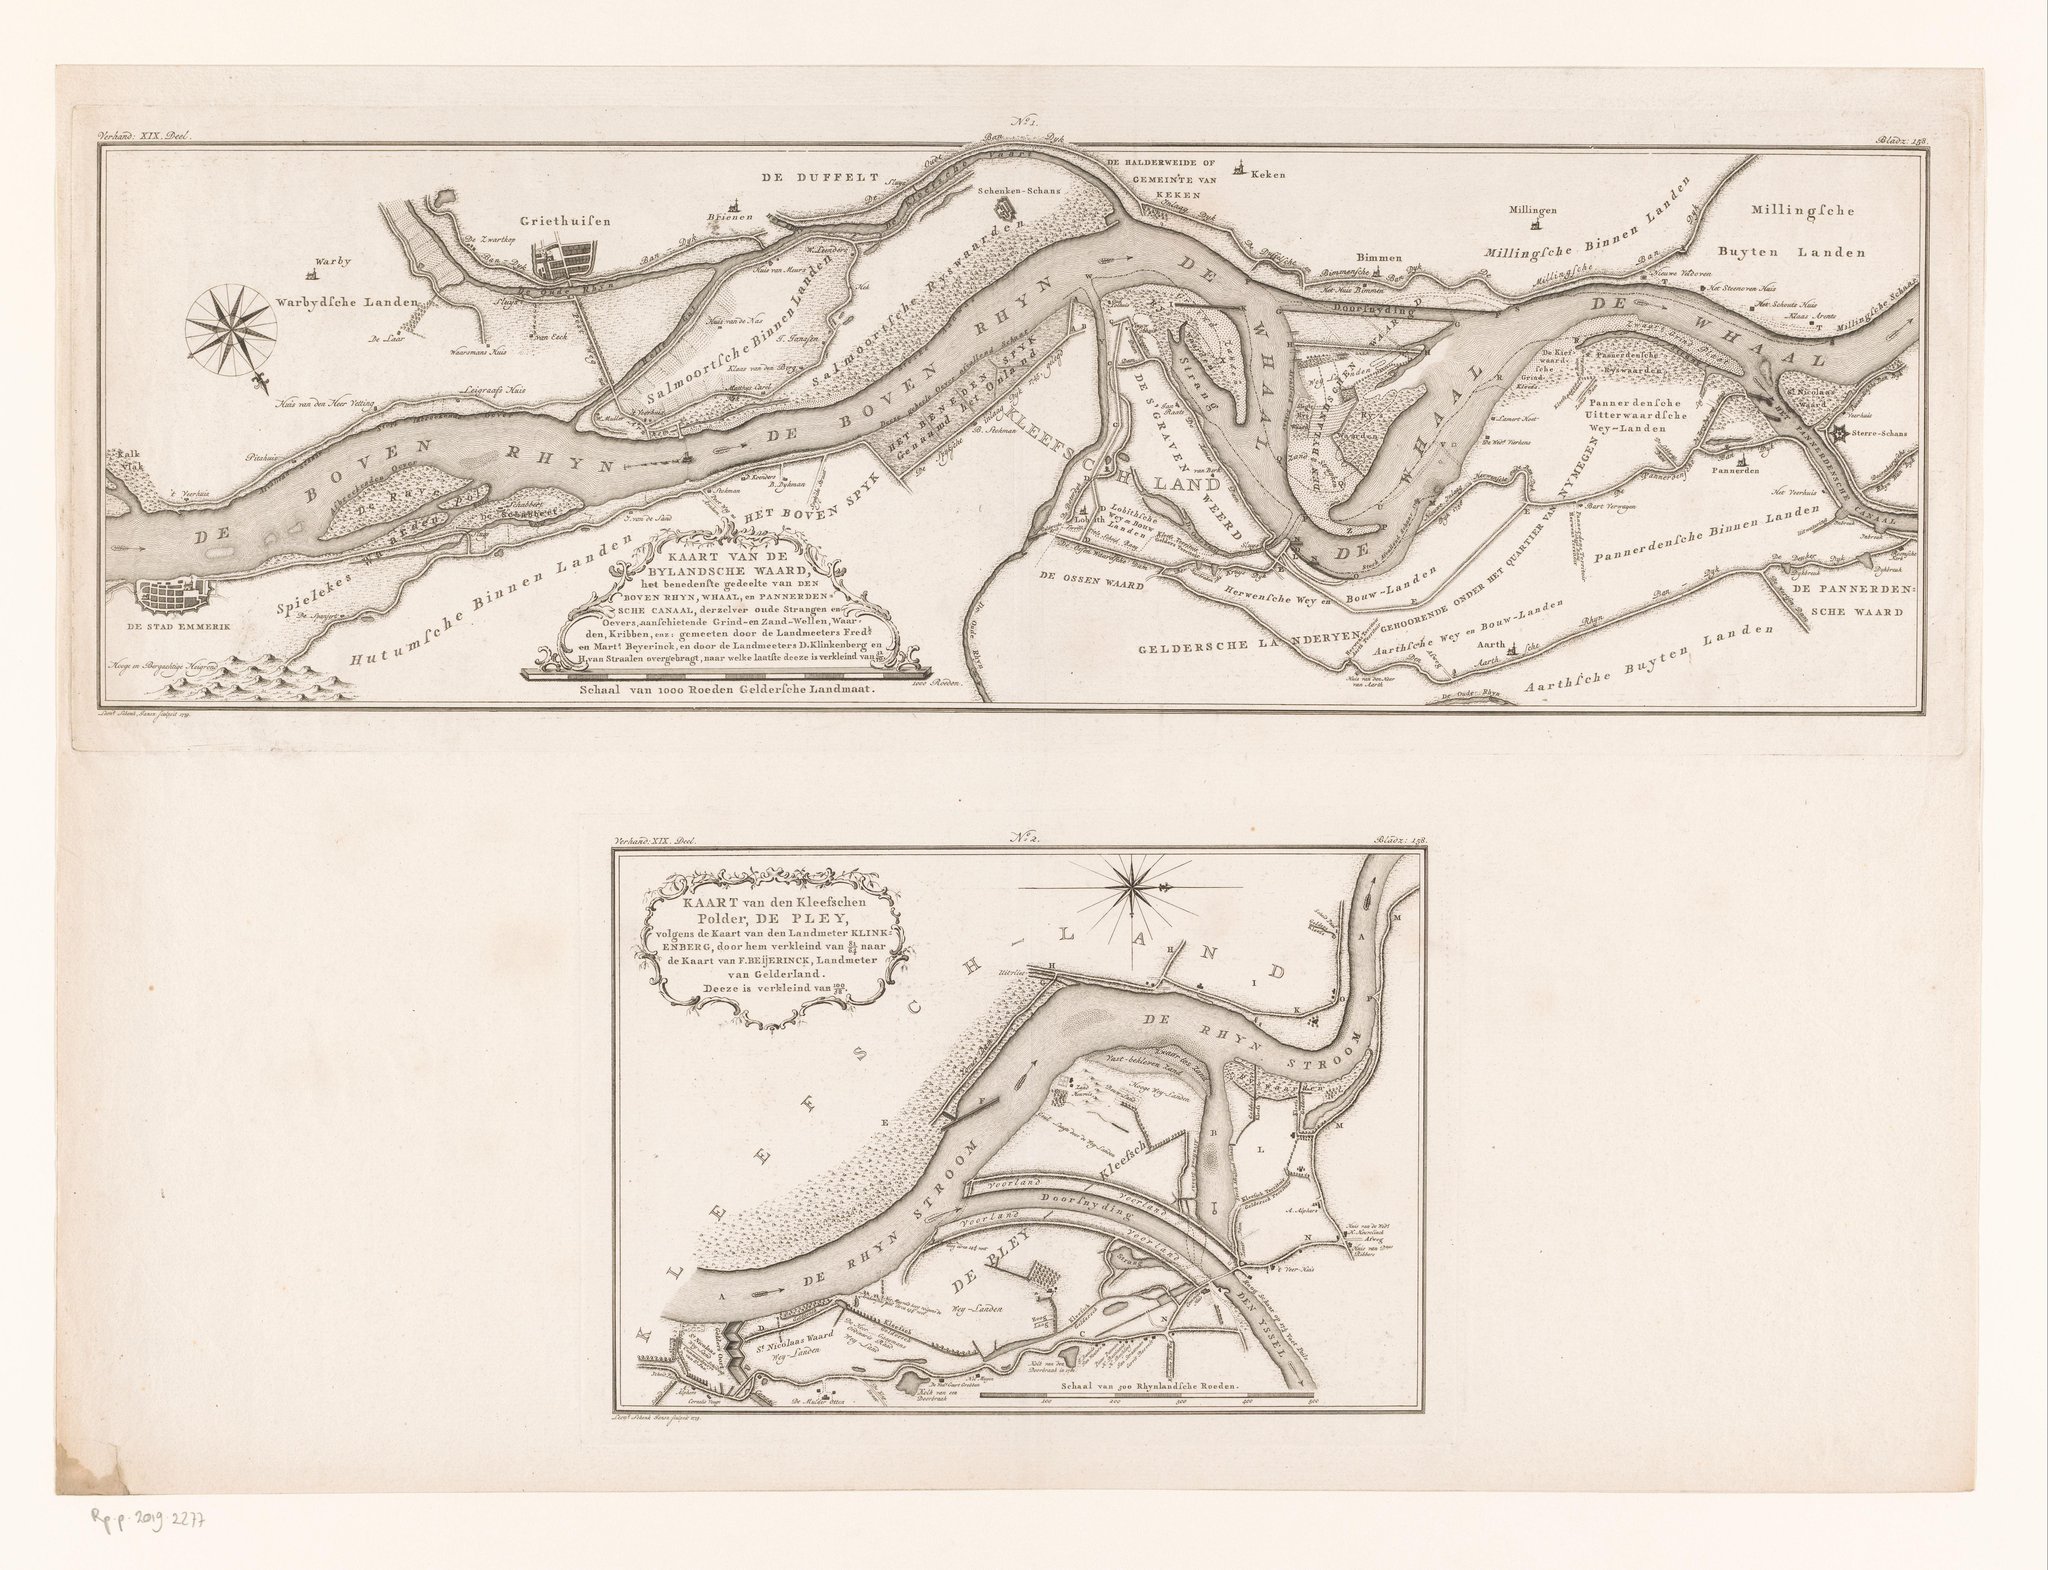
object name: map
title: Kaart van de Bylandsche waard, het benedenste gedeelte van (...) / Kaart van den Kleefschen Polder, de Pley, volgens de kaart (...)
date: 1779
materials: paper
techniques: engraving, etching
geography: amsterdam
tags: maps of separate countries or regions, river, gelderland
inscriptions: collector's mark: Lugt 2228, collector's mark: Lugt 2760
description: Boven een kaart van het verloop van de Rijn tussen Emmerik en Pannerden. Onder een kaart van het verloop van de Rijn bij de polder de Pley.